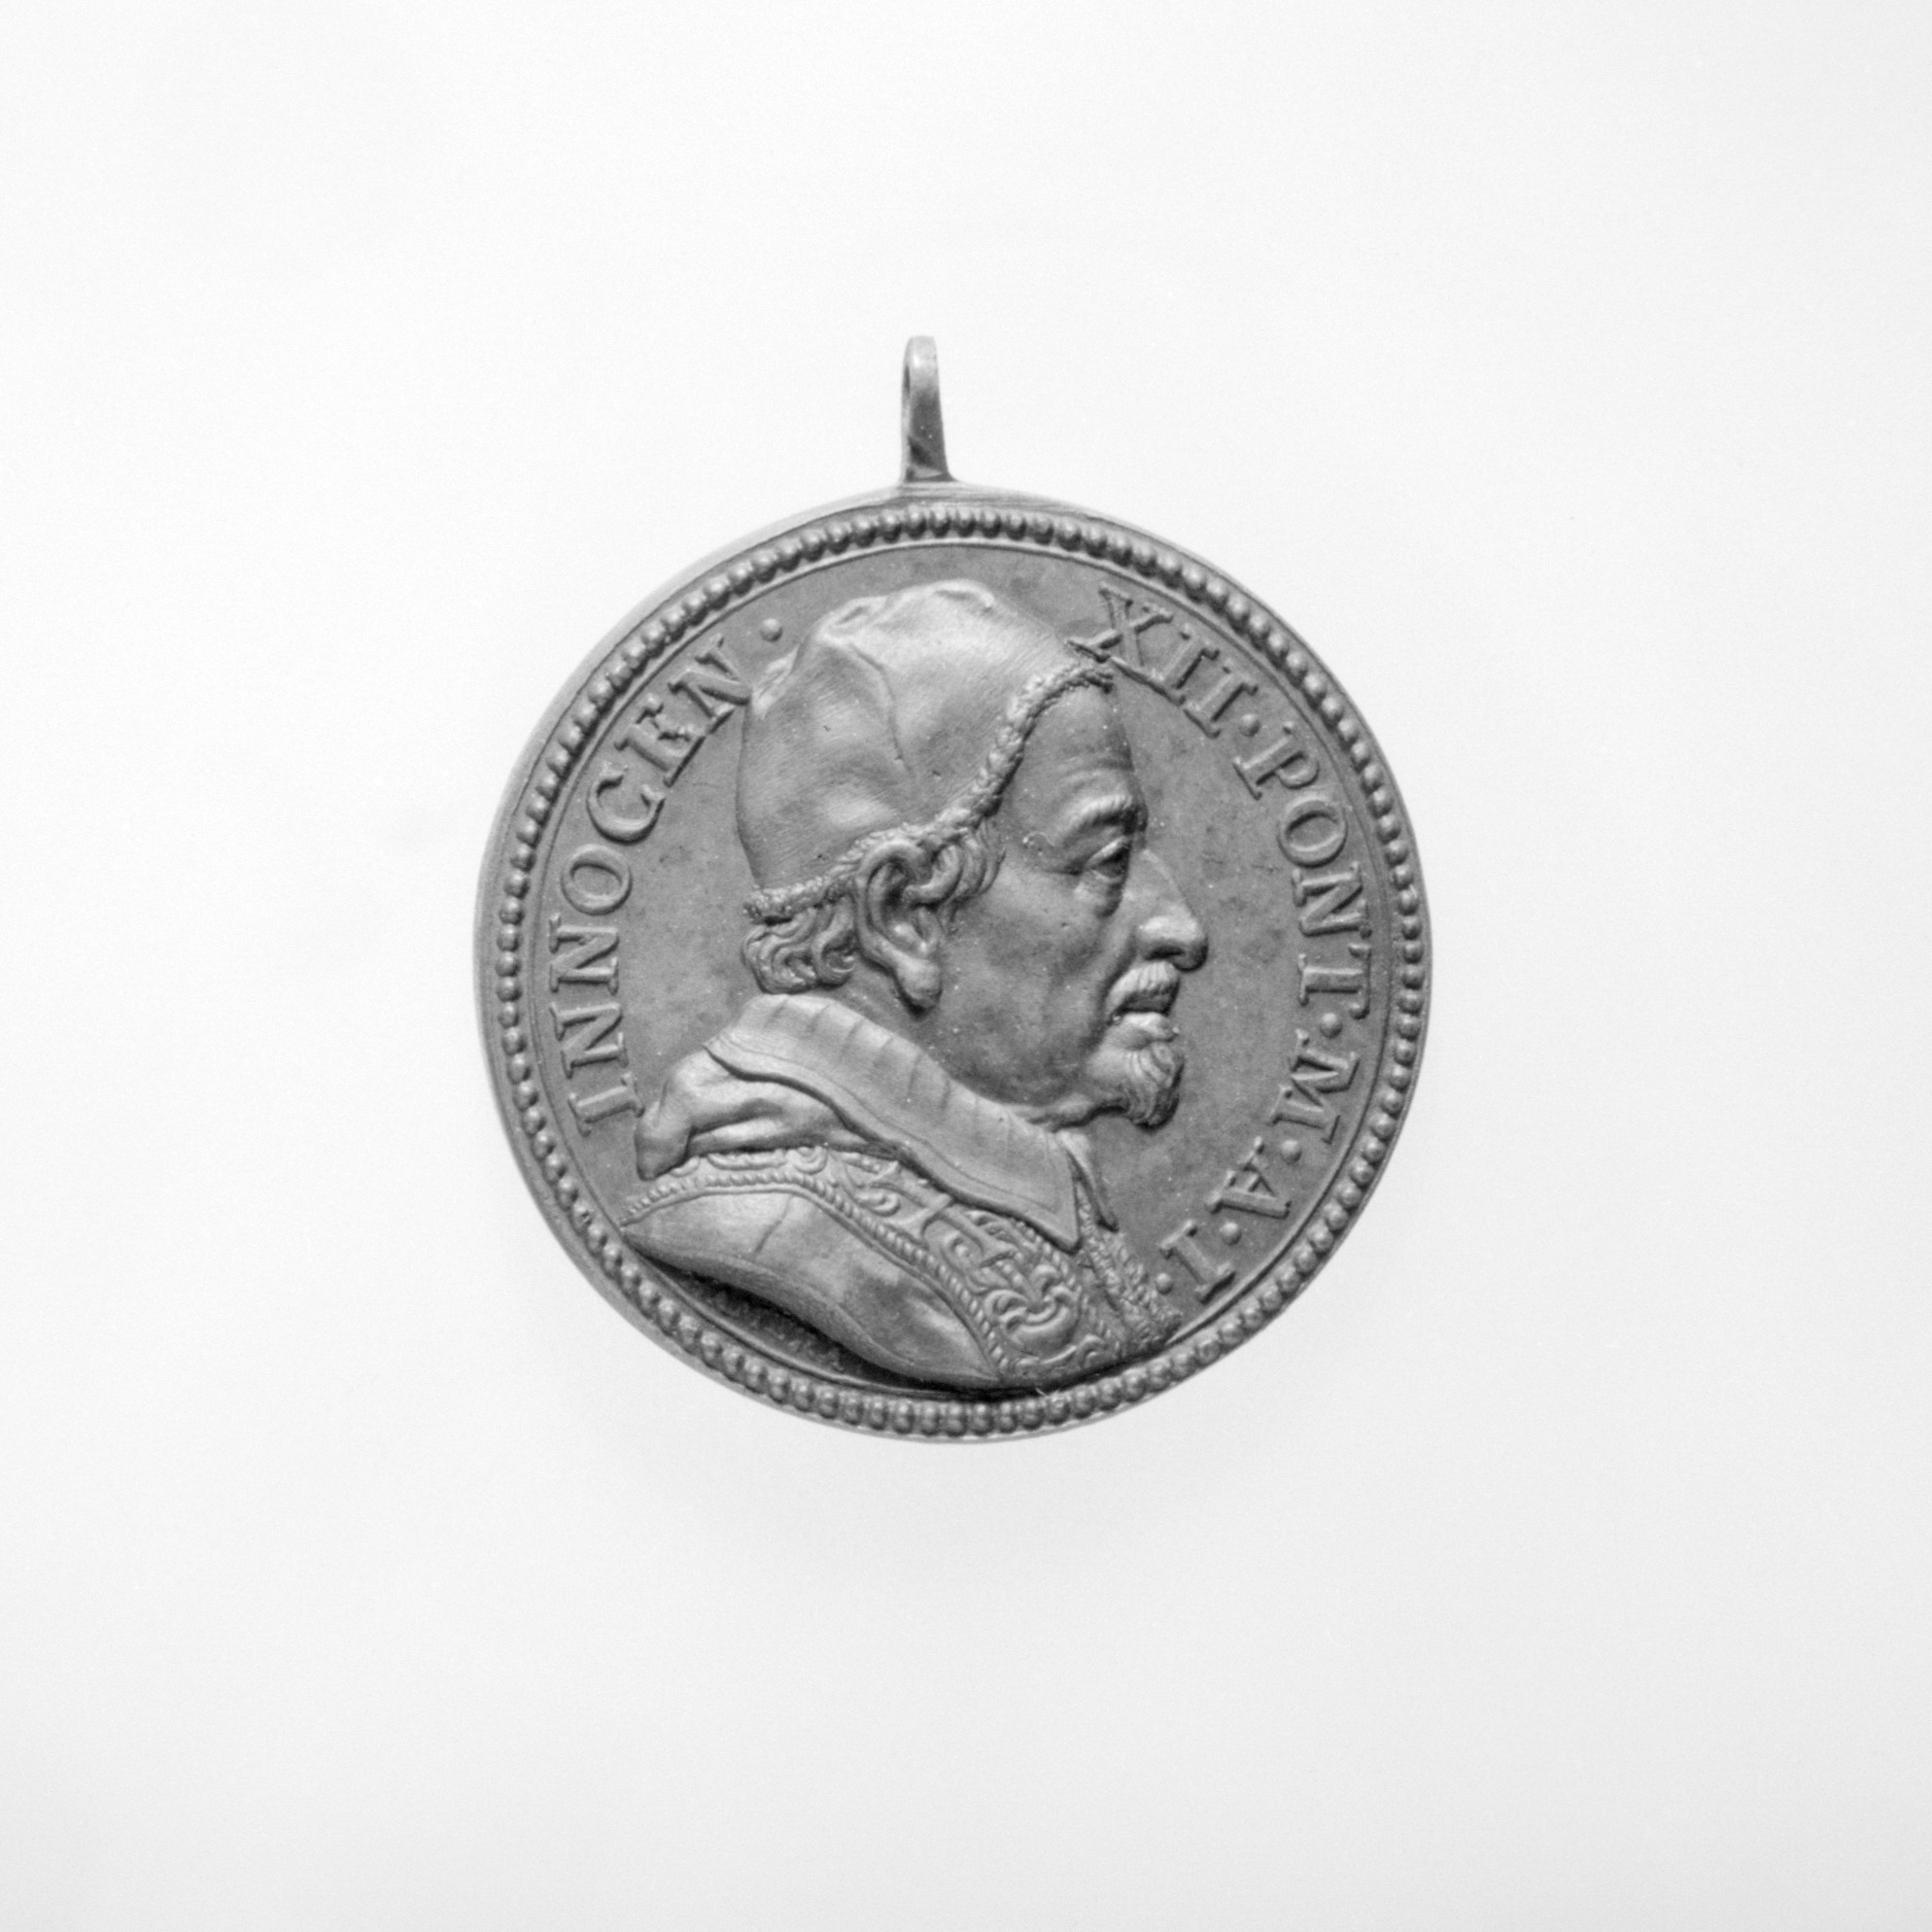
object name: medal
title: Innocent XII (Pope, 1691–1700)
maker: giovanni martino hamerani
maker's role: artist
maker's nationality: italian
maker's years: 1646-1705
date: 1601-1700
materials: bronze, patina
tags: profiles,popes